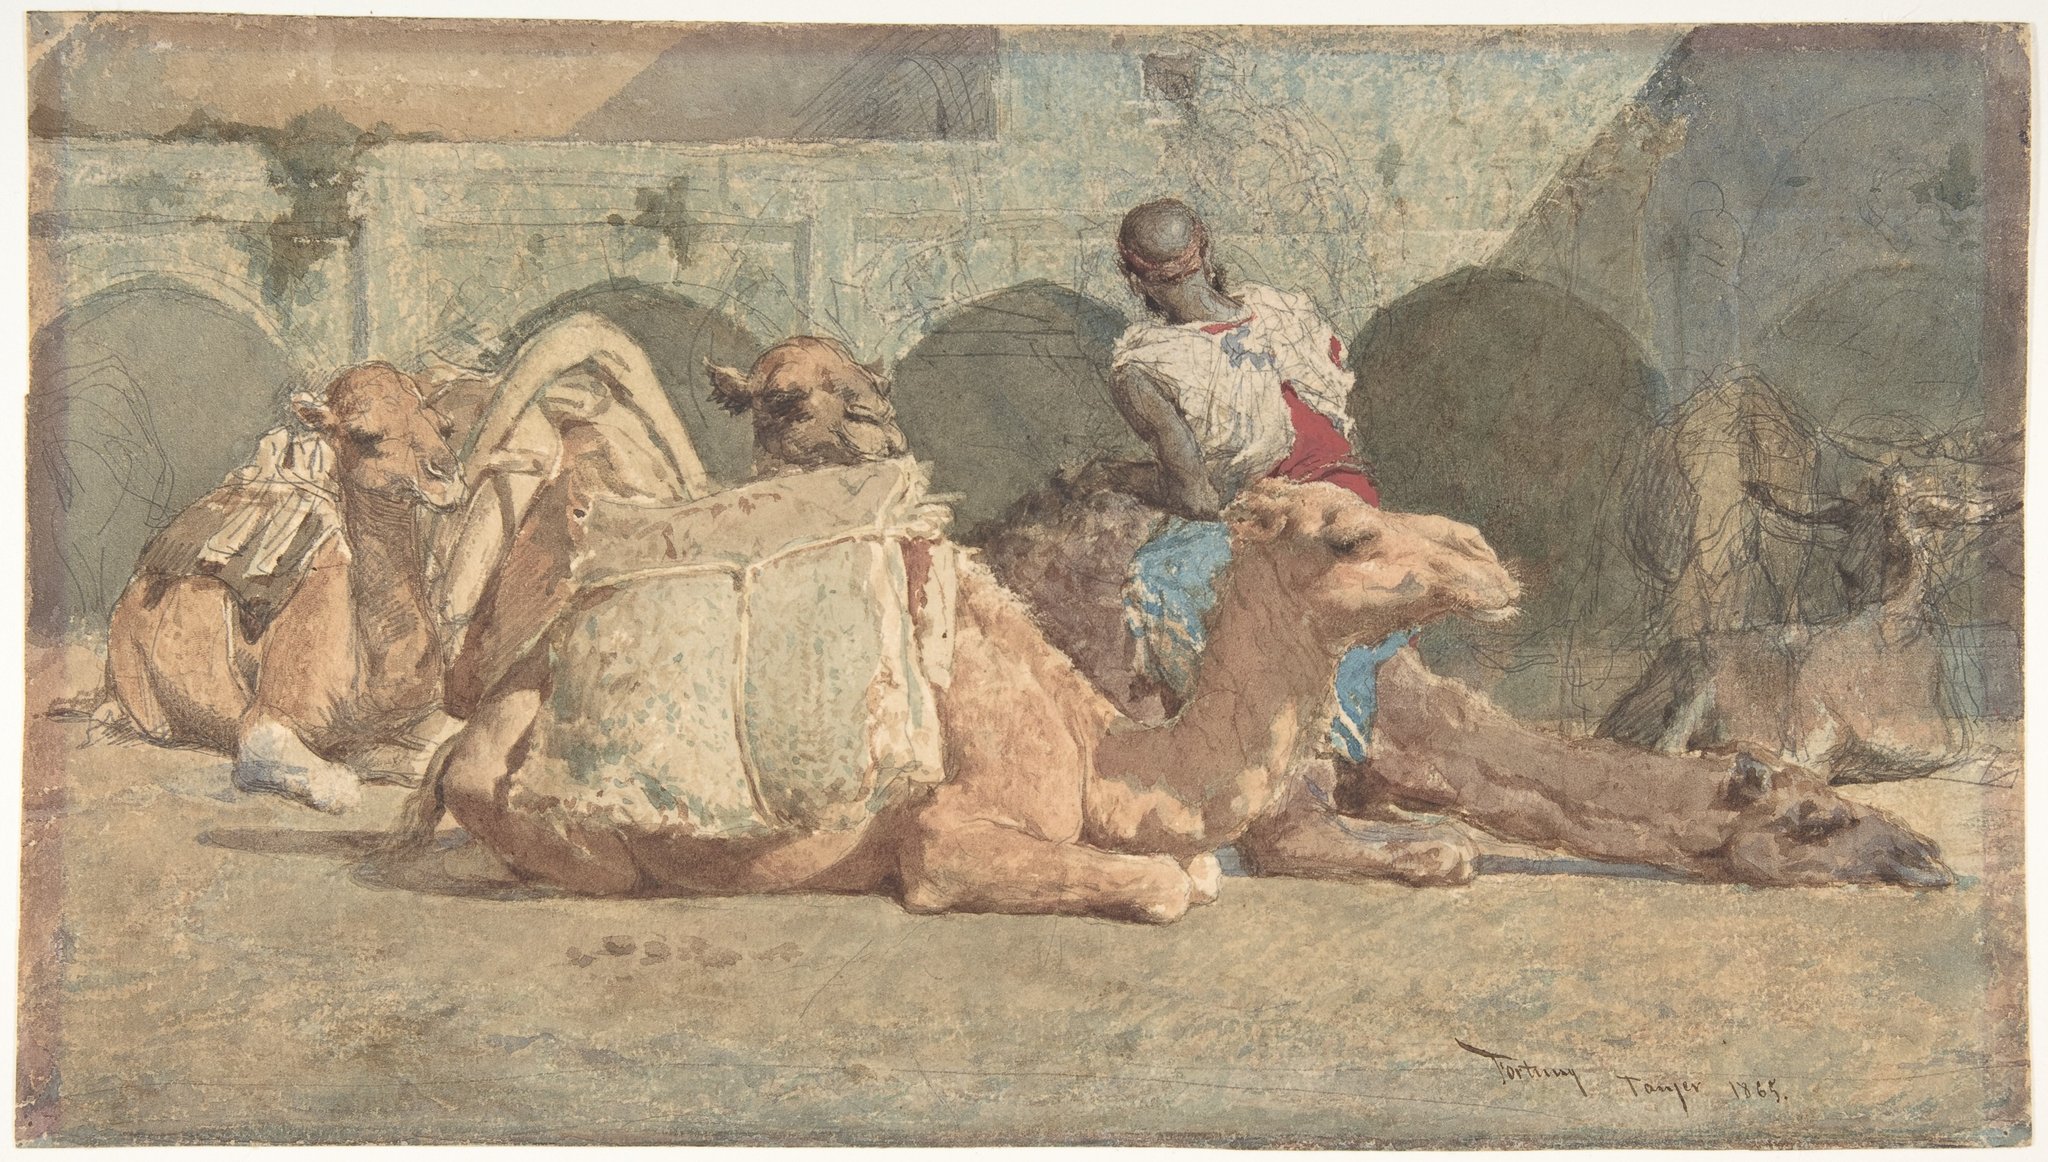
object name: drawing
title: Camels Reposing, Tangiers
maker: mariano fortuny, 1838–1874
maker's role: artist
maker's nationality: spanish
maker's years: 1838-1874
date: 1865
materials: graphite, paper, watercolor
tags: men,camels